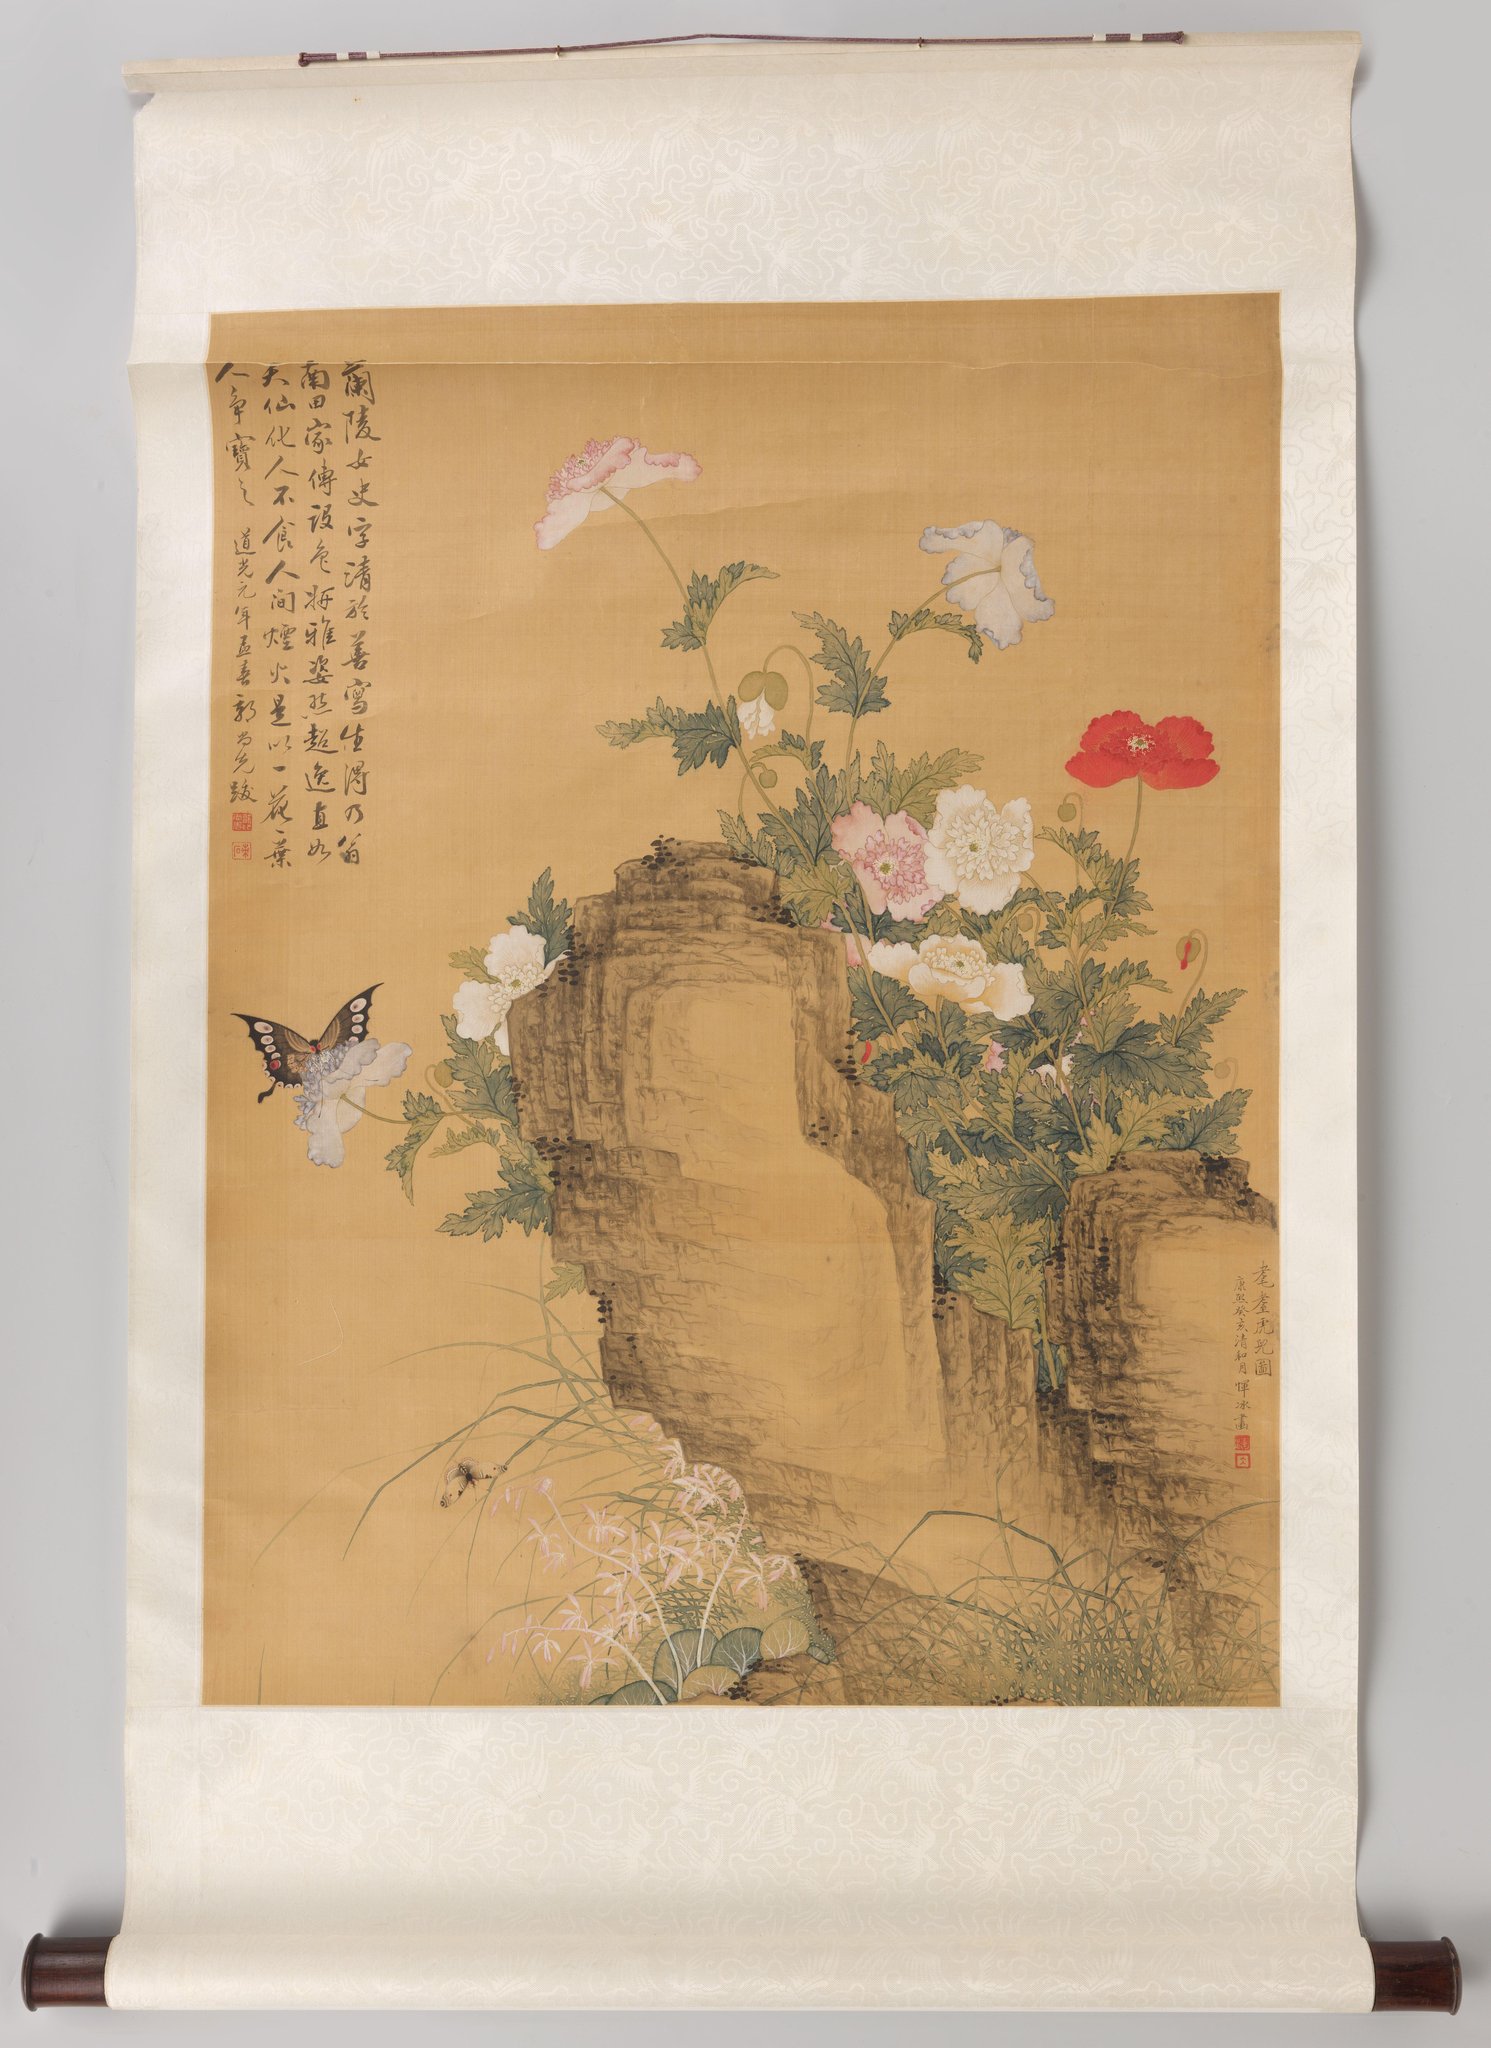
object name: hanging scroll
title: Hangrol met papavers, vlinders en een kat (bovenste gedeelte)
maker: yun bing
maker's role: painter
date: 1683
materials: ink, silk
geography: changzhou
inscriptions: date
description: Hangrol met papavers, vlinders en een kat (bovenste gedeelte).